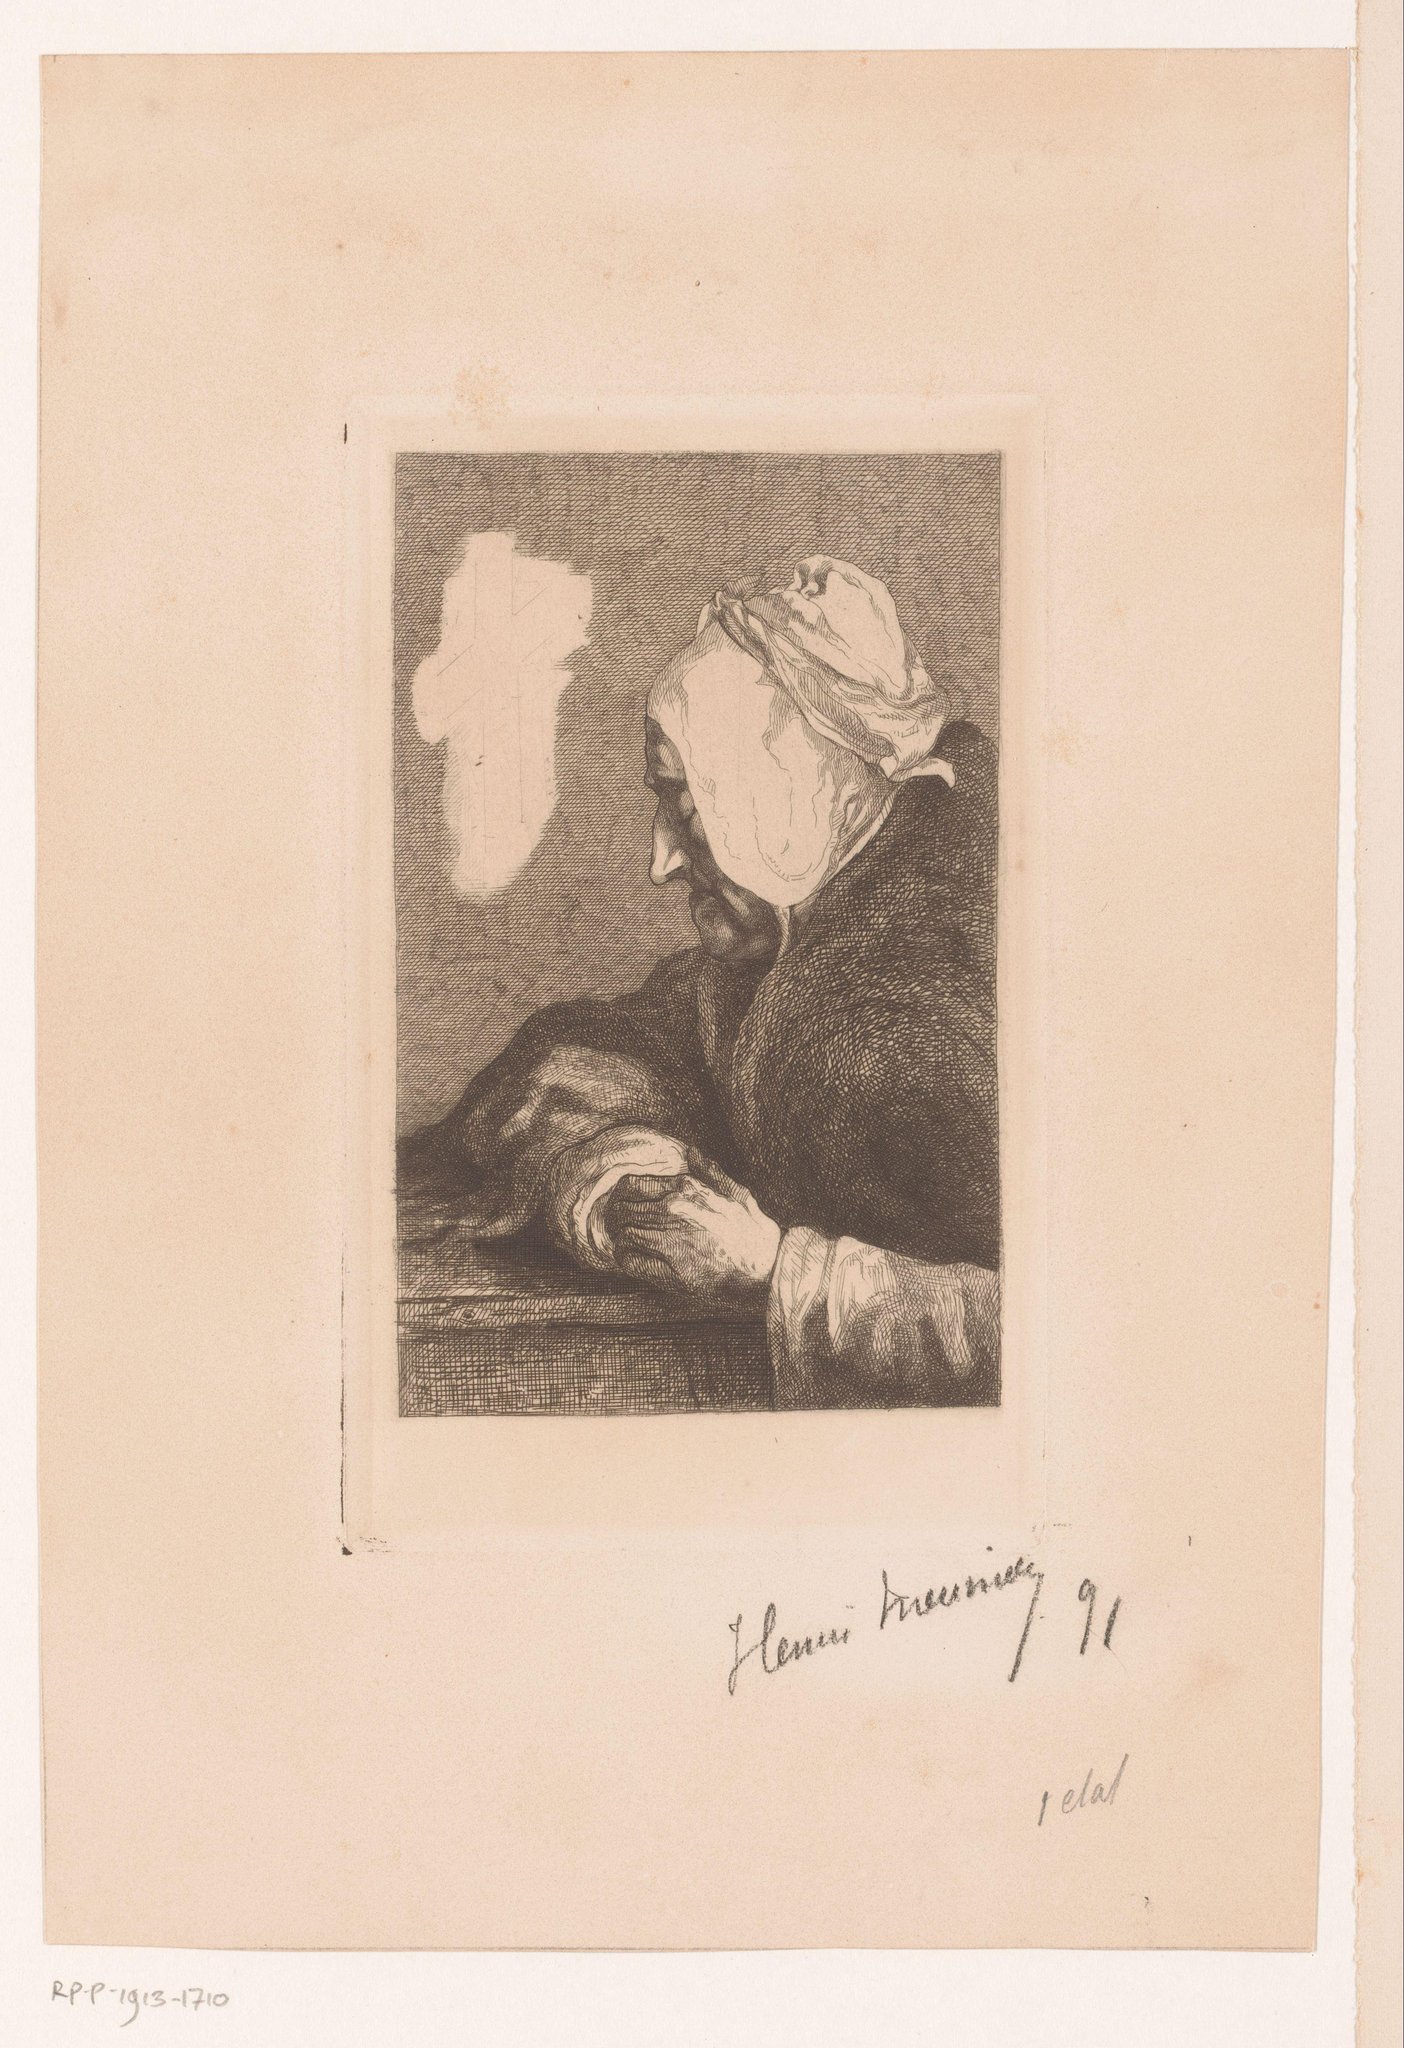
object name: print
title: Oude vrouw met kapje heeft een visioen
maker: marc henry meunier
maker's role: print maker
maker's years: 1873-1922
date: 1891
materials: paper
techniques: etching, intaglio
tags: cross as symbol of christ, old woman, vision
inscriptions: inscription: ‘1 etat’, collector's mark: Lugt 2228